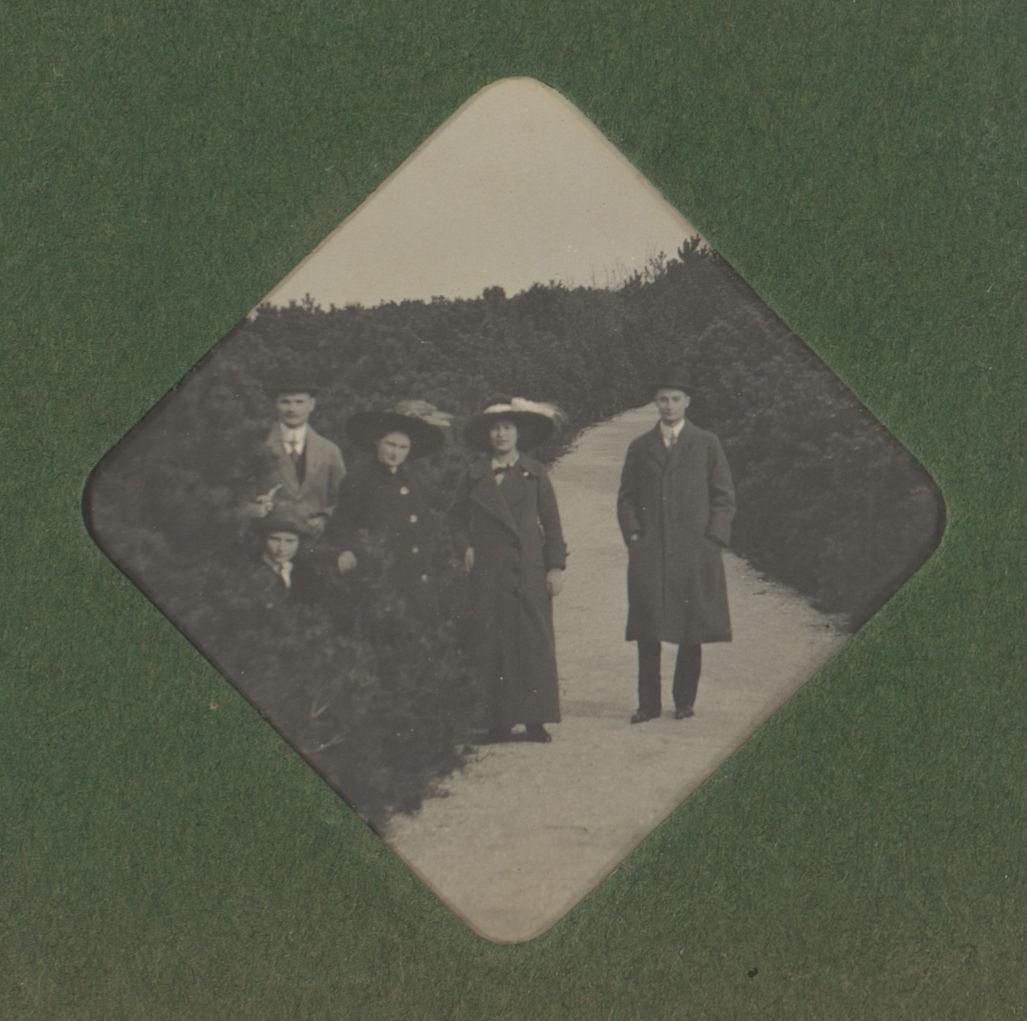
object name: album leaf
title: Jan Hellendoorn, Pauline van den Bussche en Wiesje Merkus met twee onbekende mensen op een duinweg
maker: Anonymous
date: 1910-1912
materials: paper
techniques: gelatin silver print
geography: netherlands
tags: wiesje merkus, adolescent, young woman, maiden, dunes (sea not visible); in the dunes, youth, adolescent, netherlands